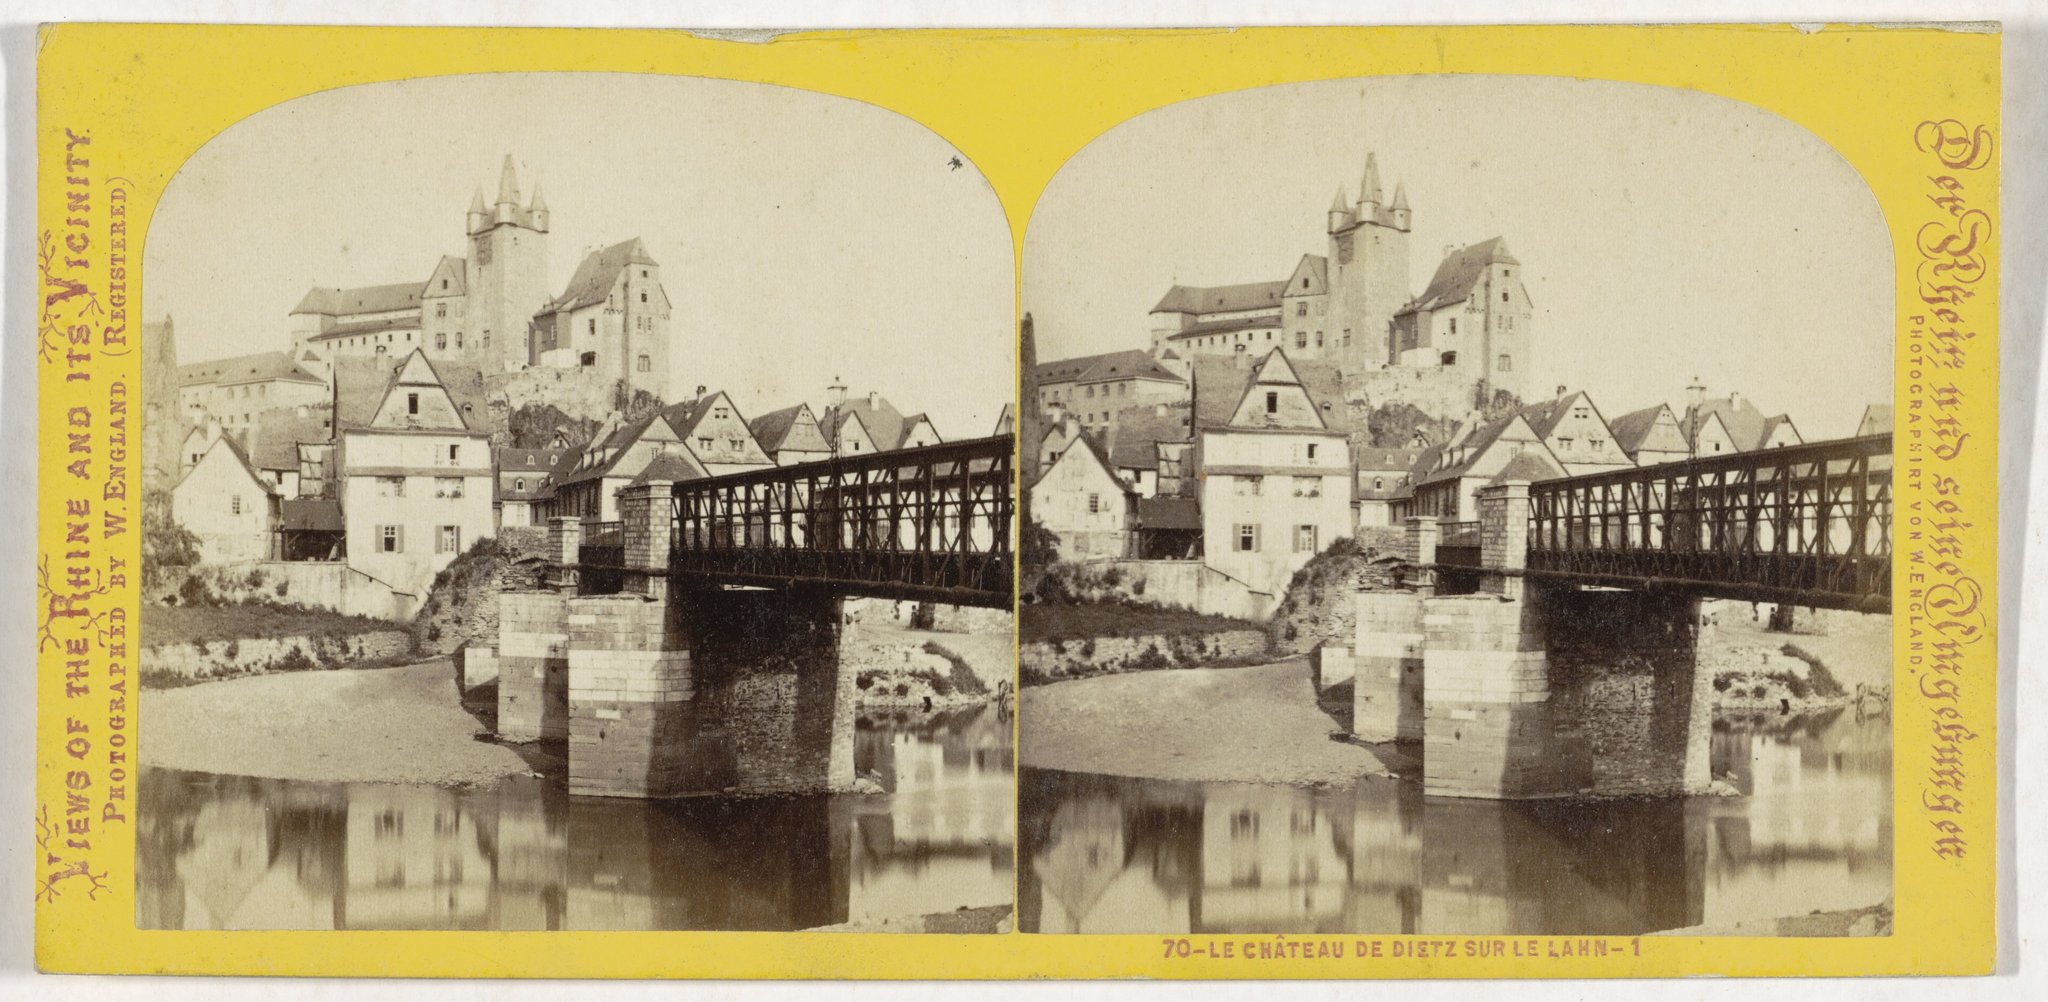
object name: stereograph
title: Views of the Rhine and its Vicinity / Der Rhein und seine Umgebungen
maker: william england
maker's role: fotograaf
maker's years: 1816-1896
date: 1867-1868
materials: cardboard, paper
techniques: albumen print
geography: diez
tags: castle, village, bridge in city across river, canal, etc.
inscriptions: number: ‘70’, inscription: ‘(Registered)’